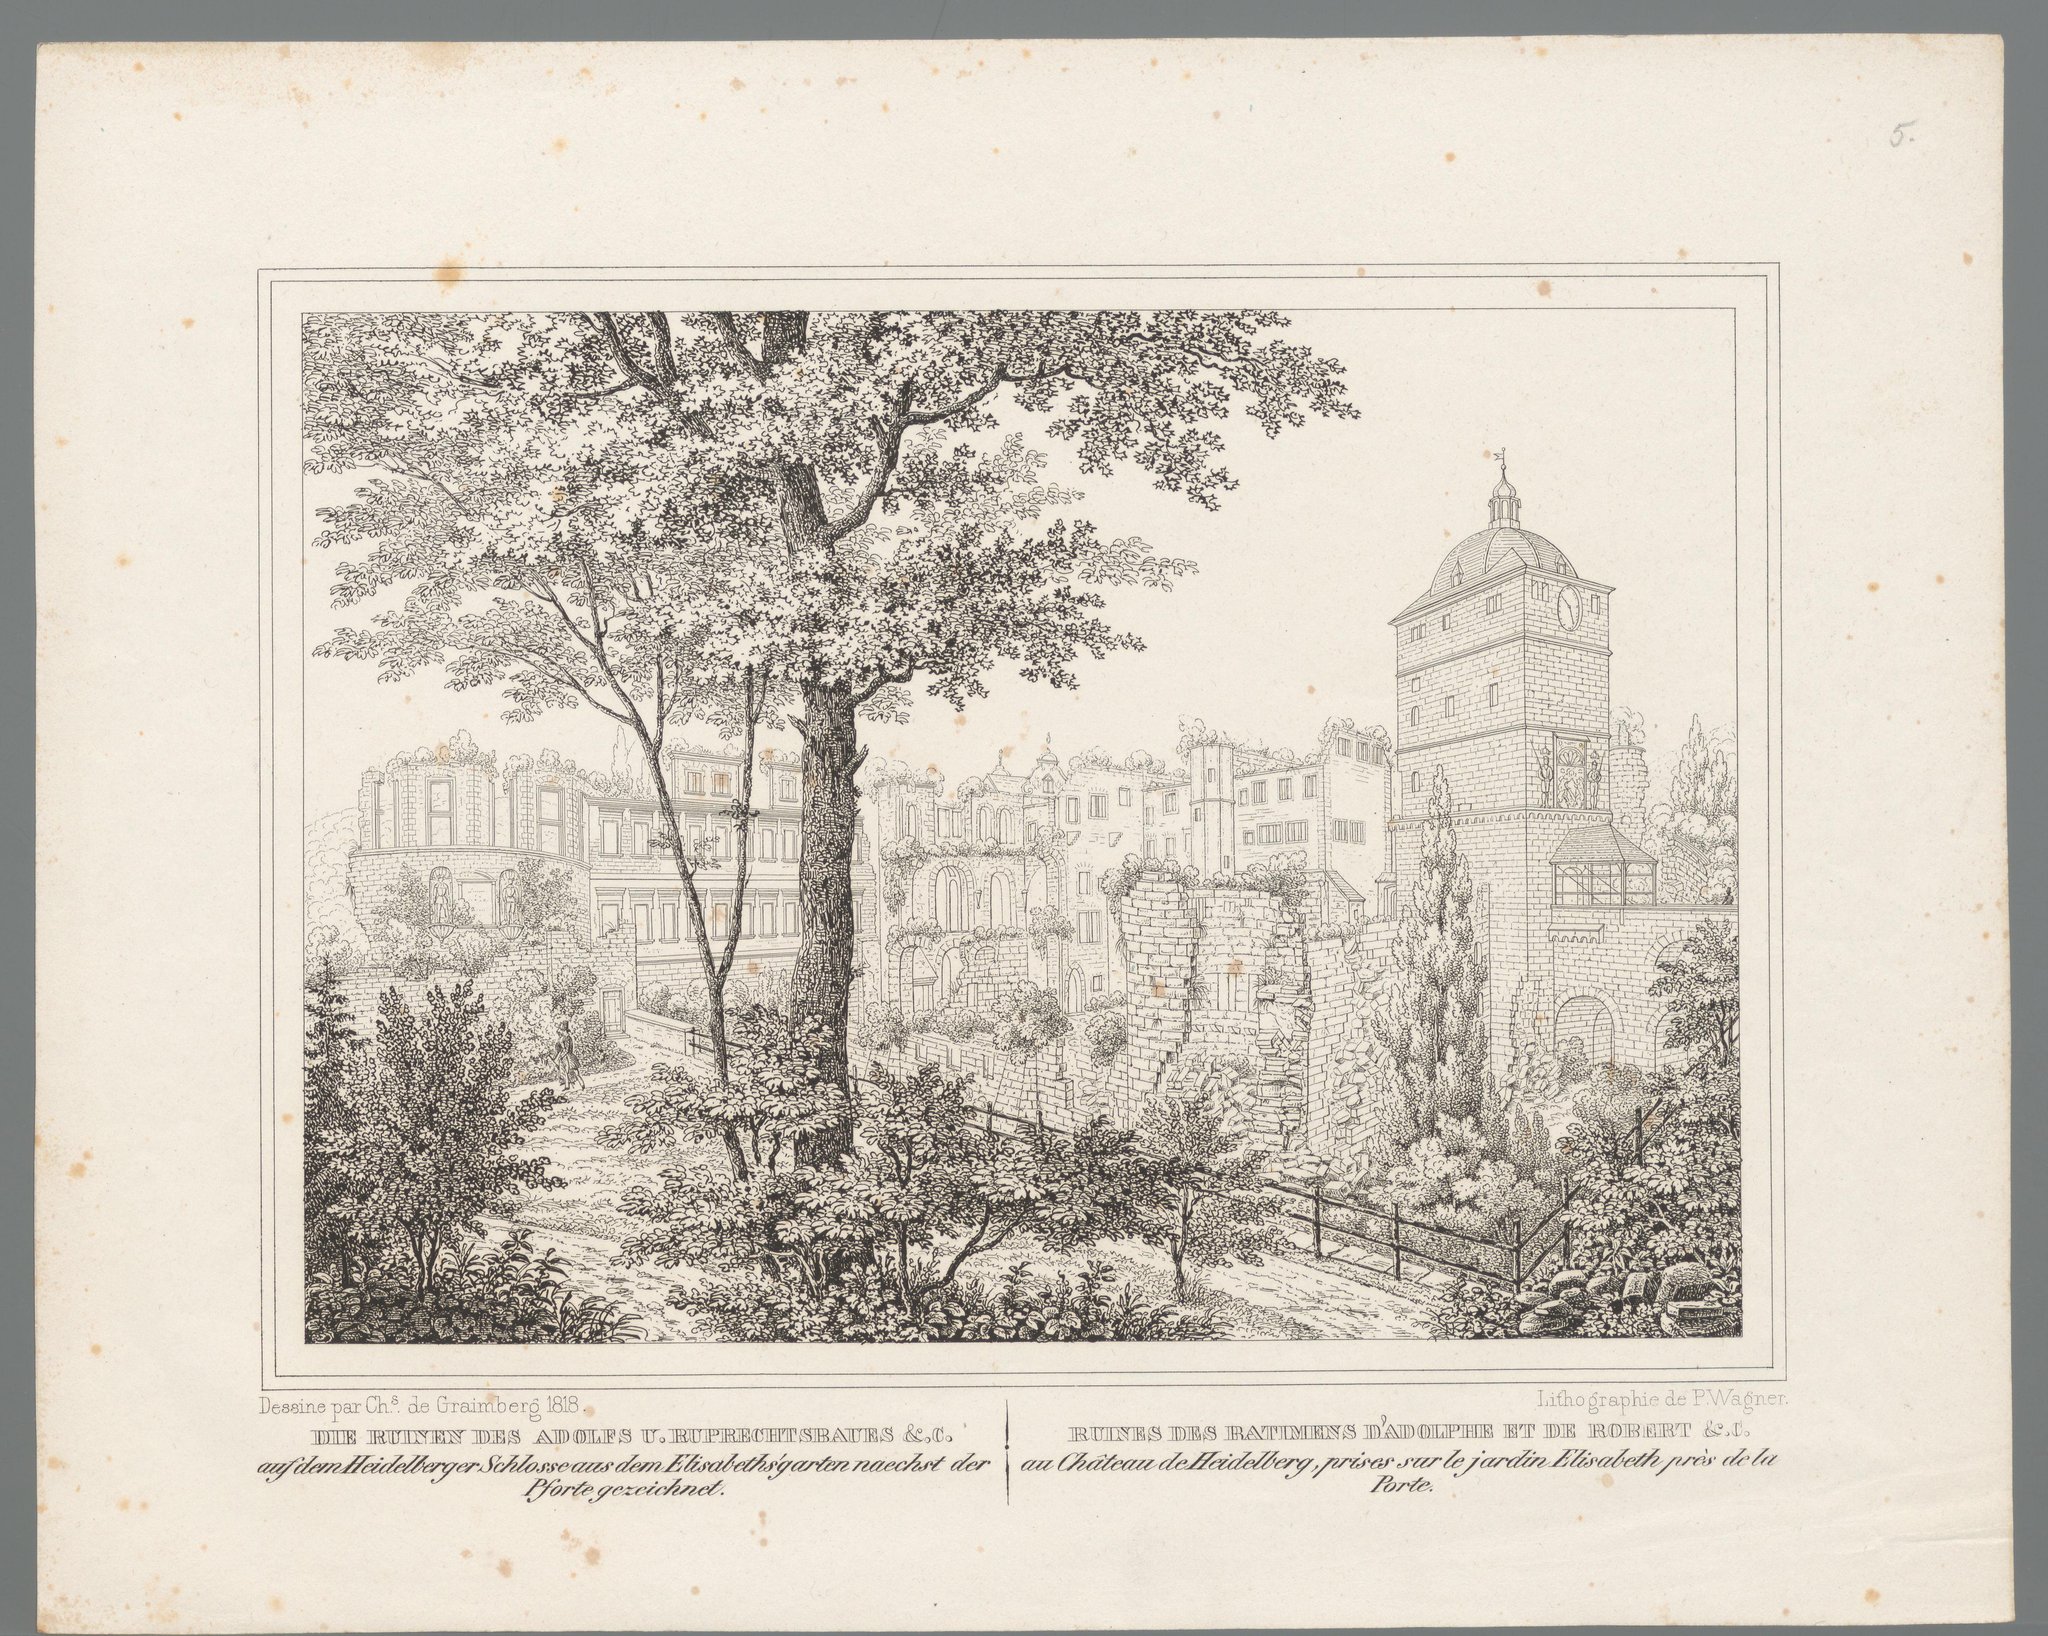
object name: print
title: Gezicht op het Heidelberger Slot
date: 1818-1830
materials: paper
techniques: lithograph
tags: trees, palace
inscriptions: collector's mark: Lugt 2233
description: Prent maakt deel uit van een serie met gezichten op het Heidelberger Slot. Over deze serie is verder niets bekend. Het betreft (ten minste) negen gezichten op het Heidelberger slot.